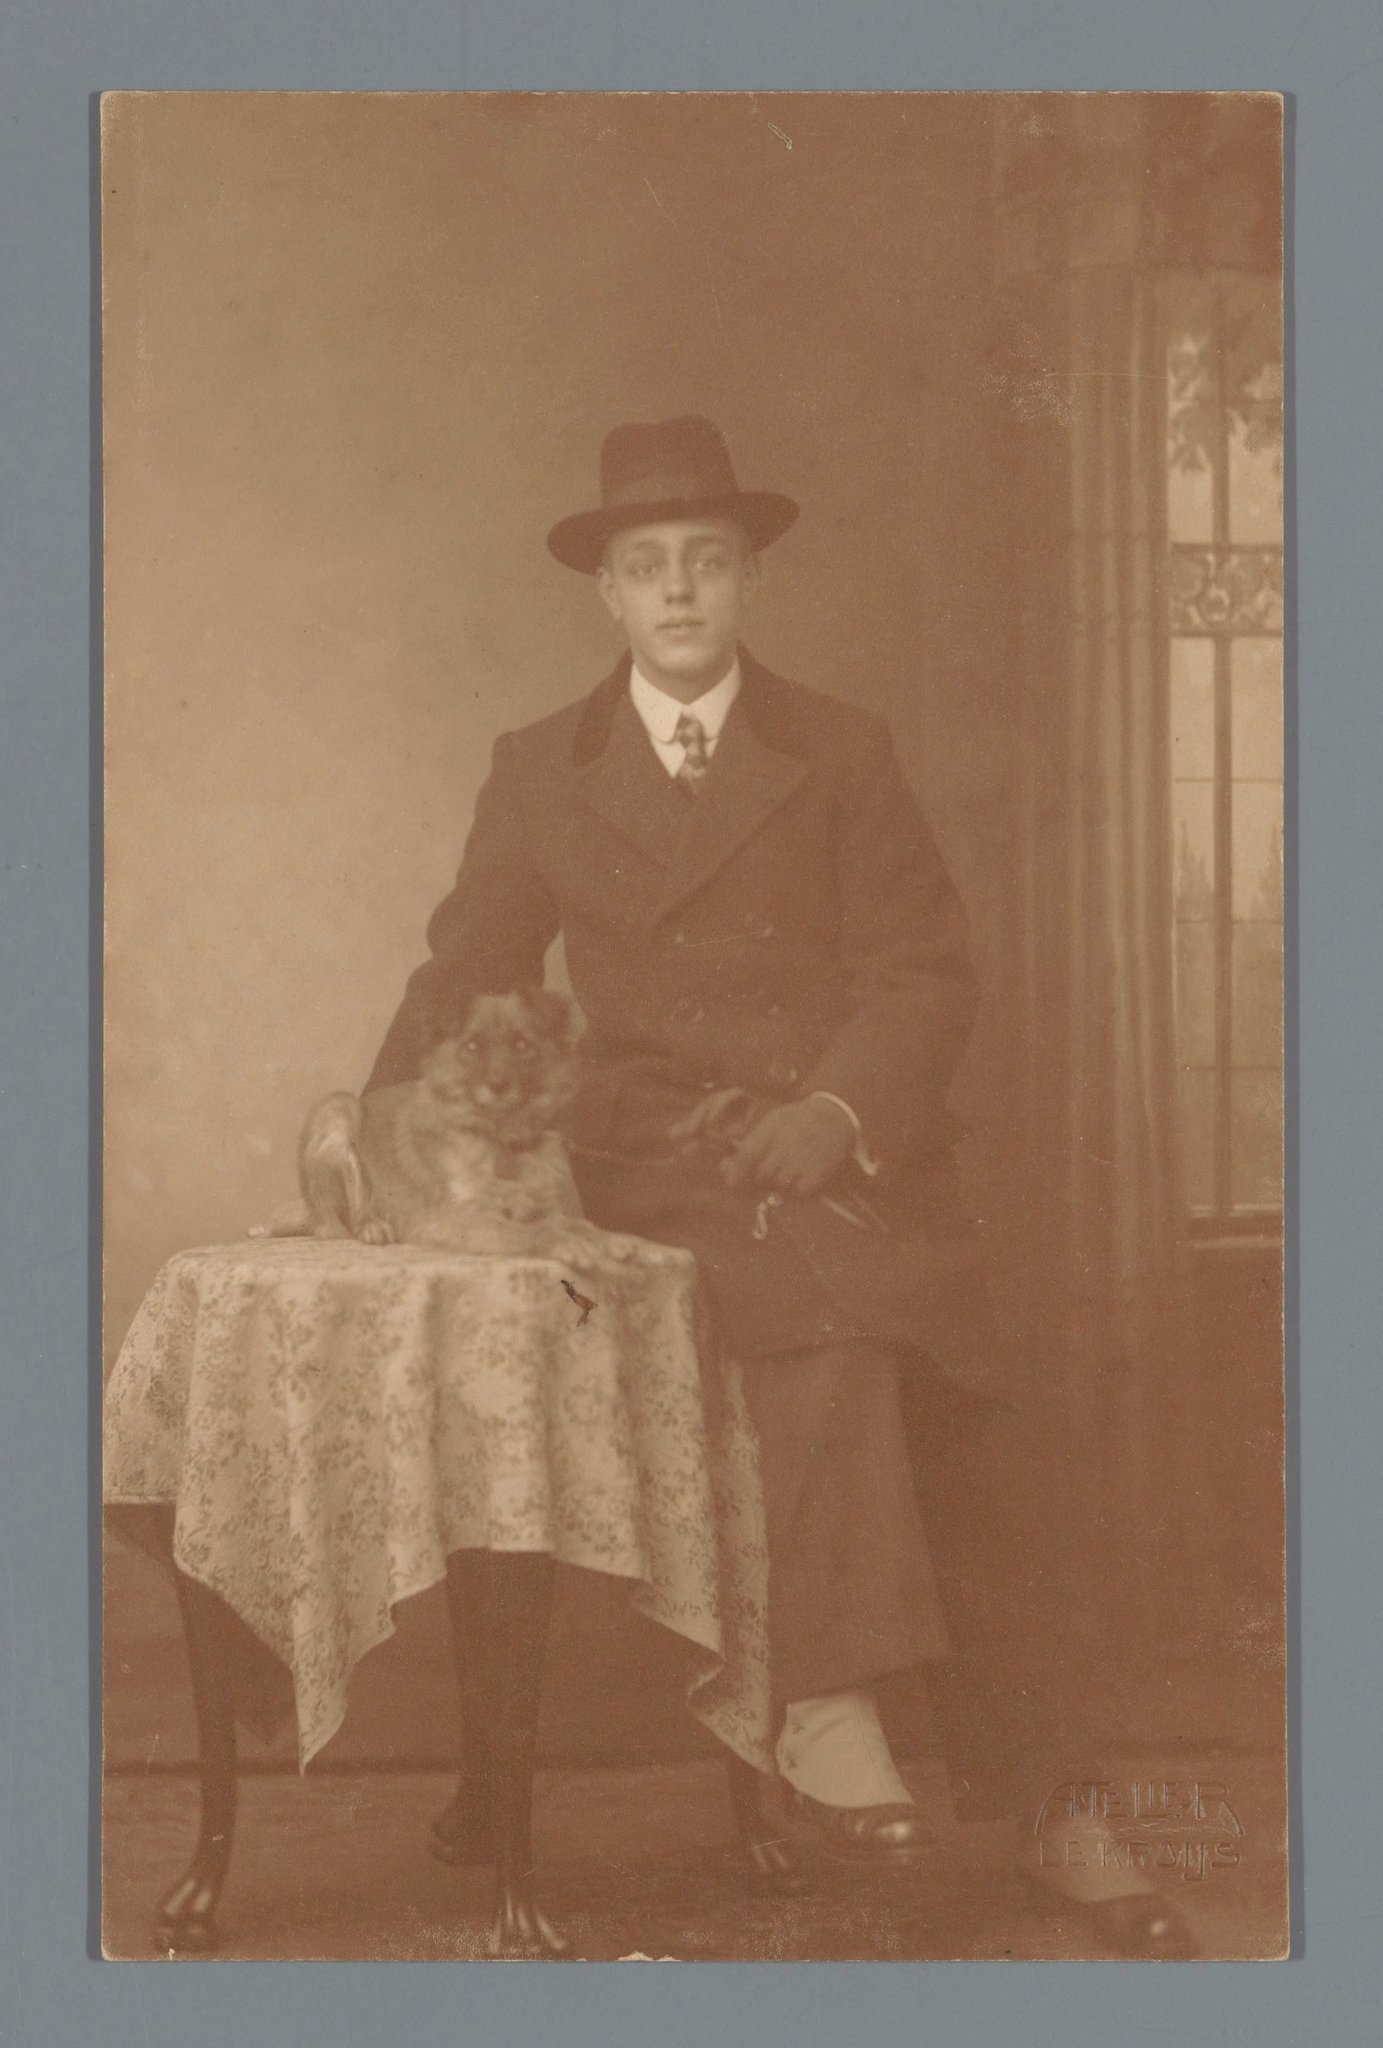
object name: ansichtkaart, prentbriefkaart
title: Studioportret van een onbekende man met een hond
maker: theodorus johannes de kruijs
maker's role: fotograaf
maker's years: 1883-1925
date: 1900-1907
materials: photographic support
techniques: gelatin silver print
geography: amsterdam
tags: adult man, dog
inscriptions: name: ‘Atelier de Kruys’